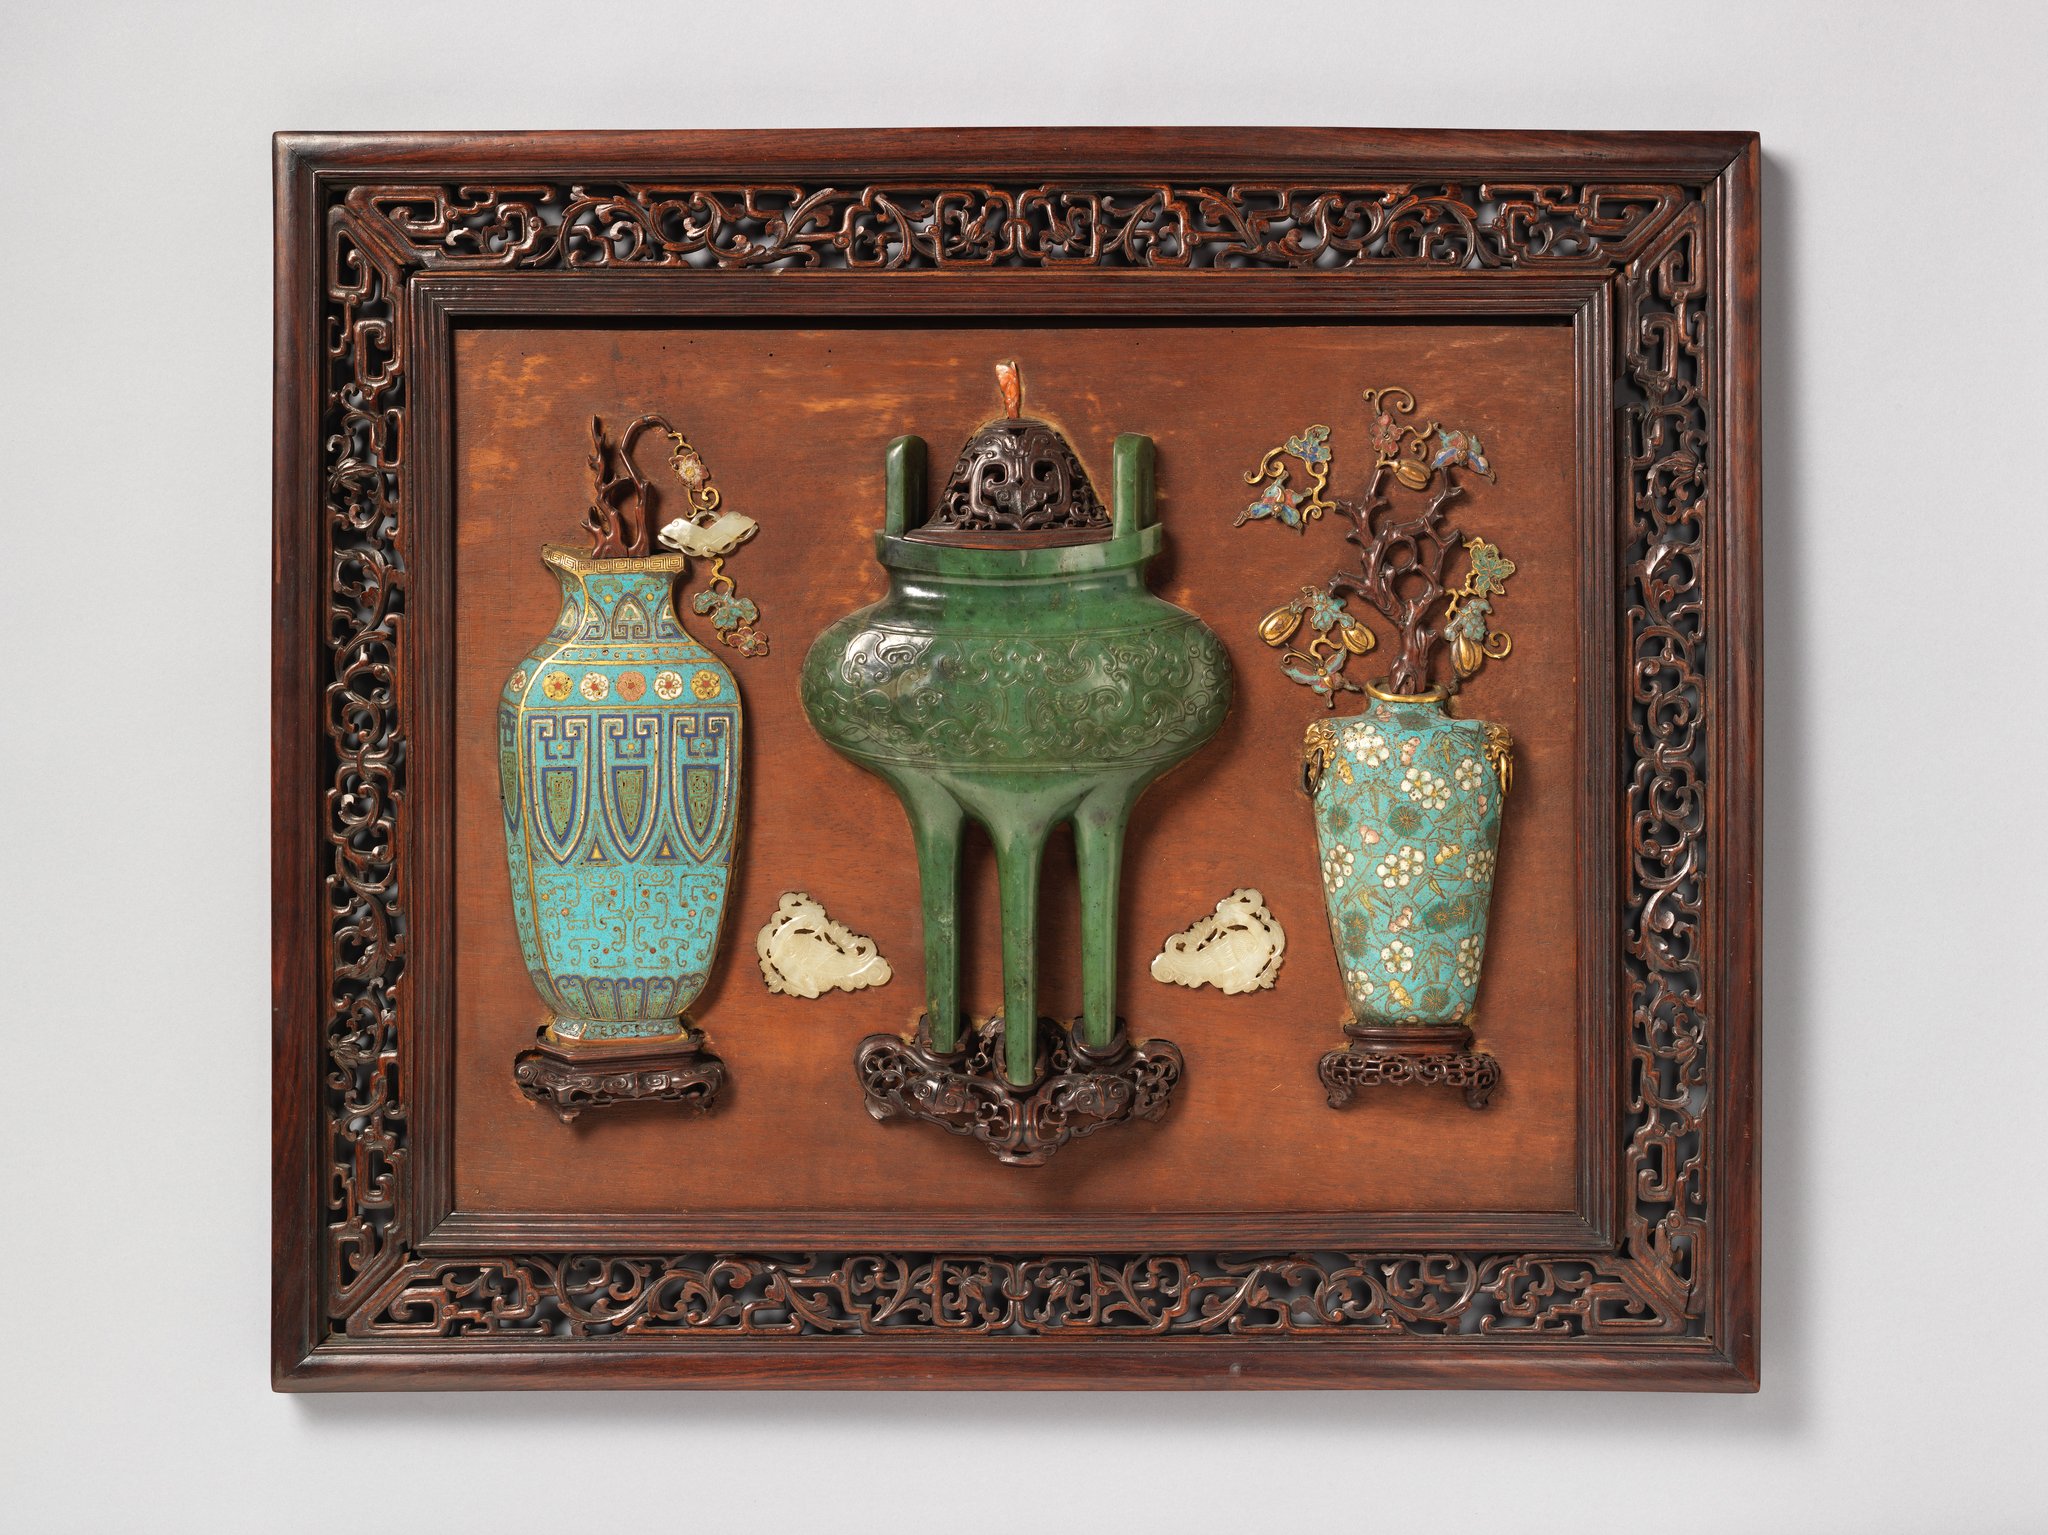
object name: panel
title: Panel with “hundred antiques”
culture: chinese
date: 1751-1800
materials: enamel, jade, wood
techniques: enamel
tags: flowers